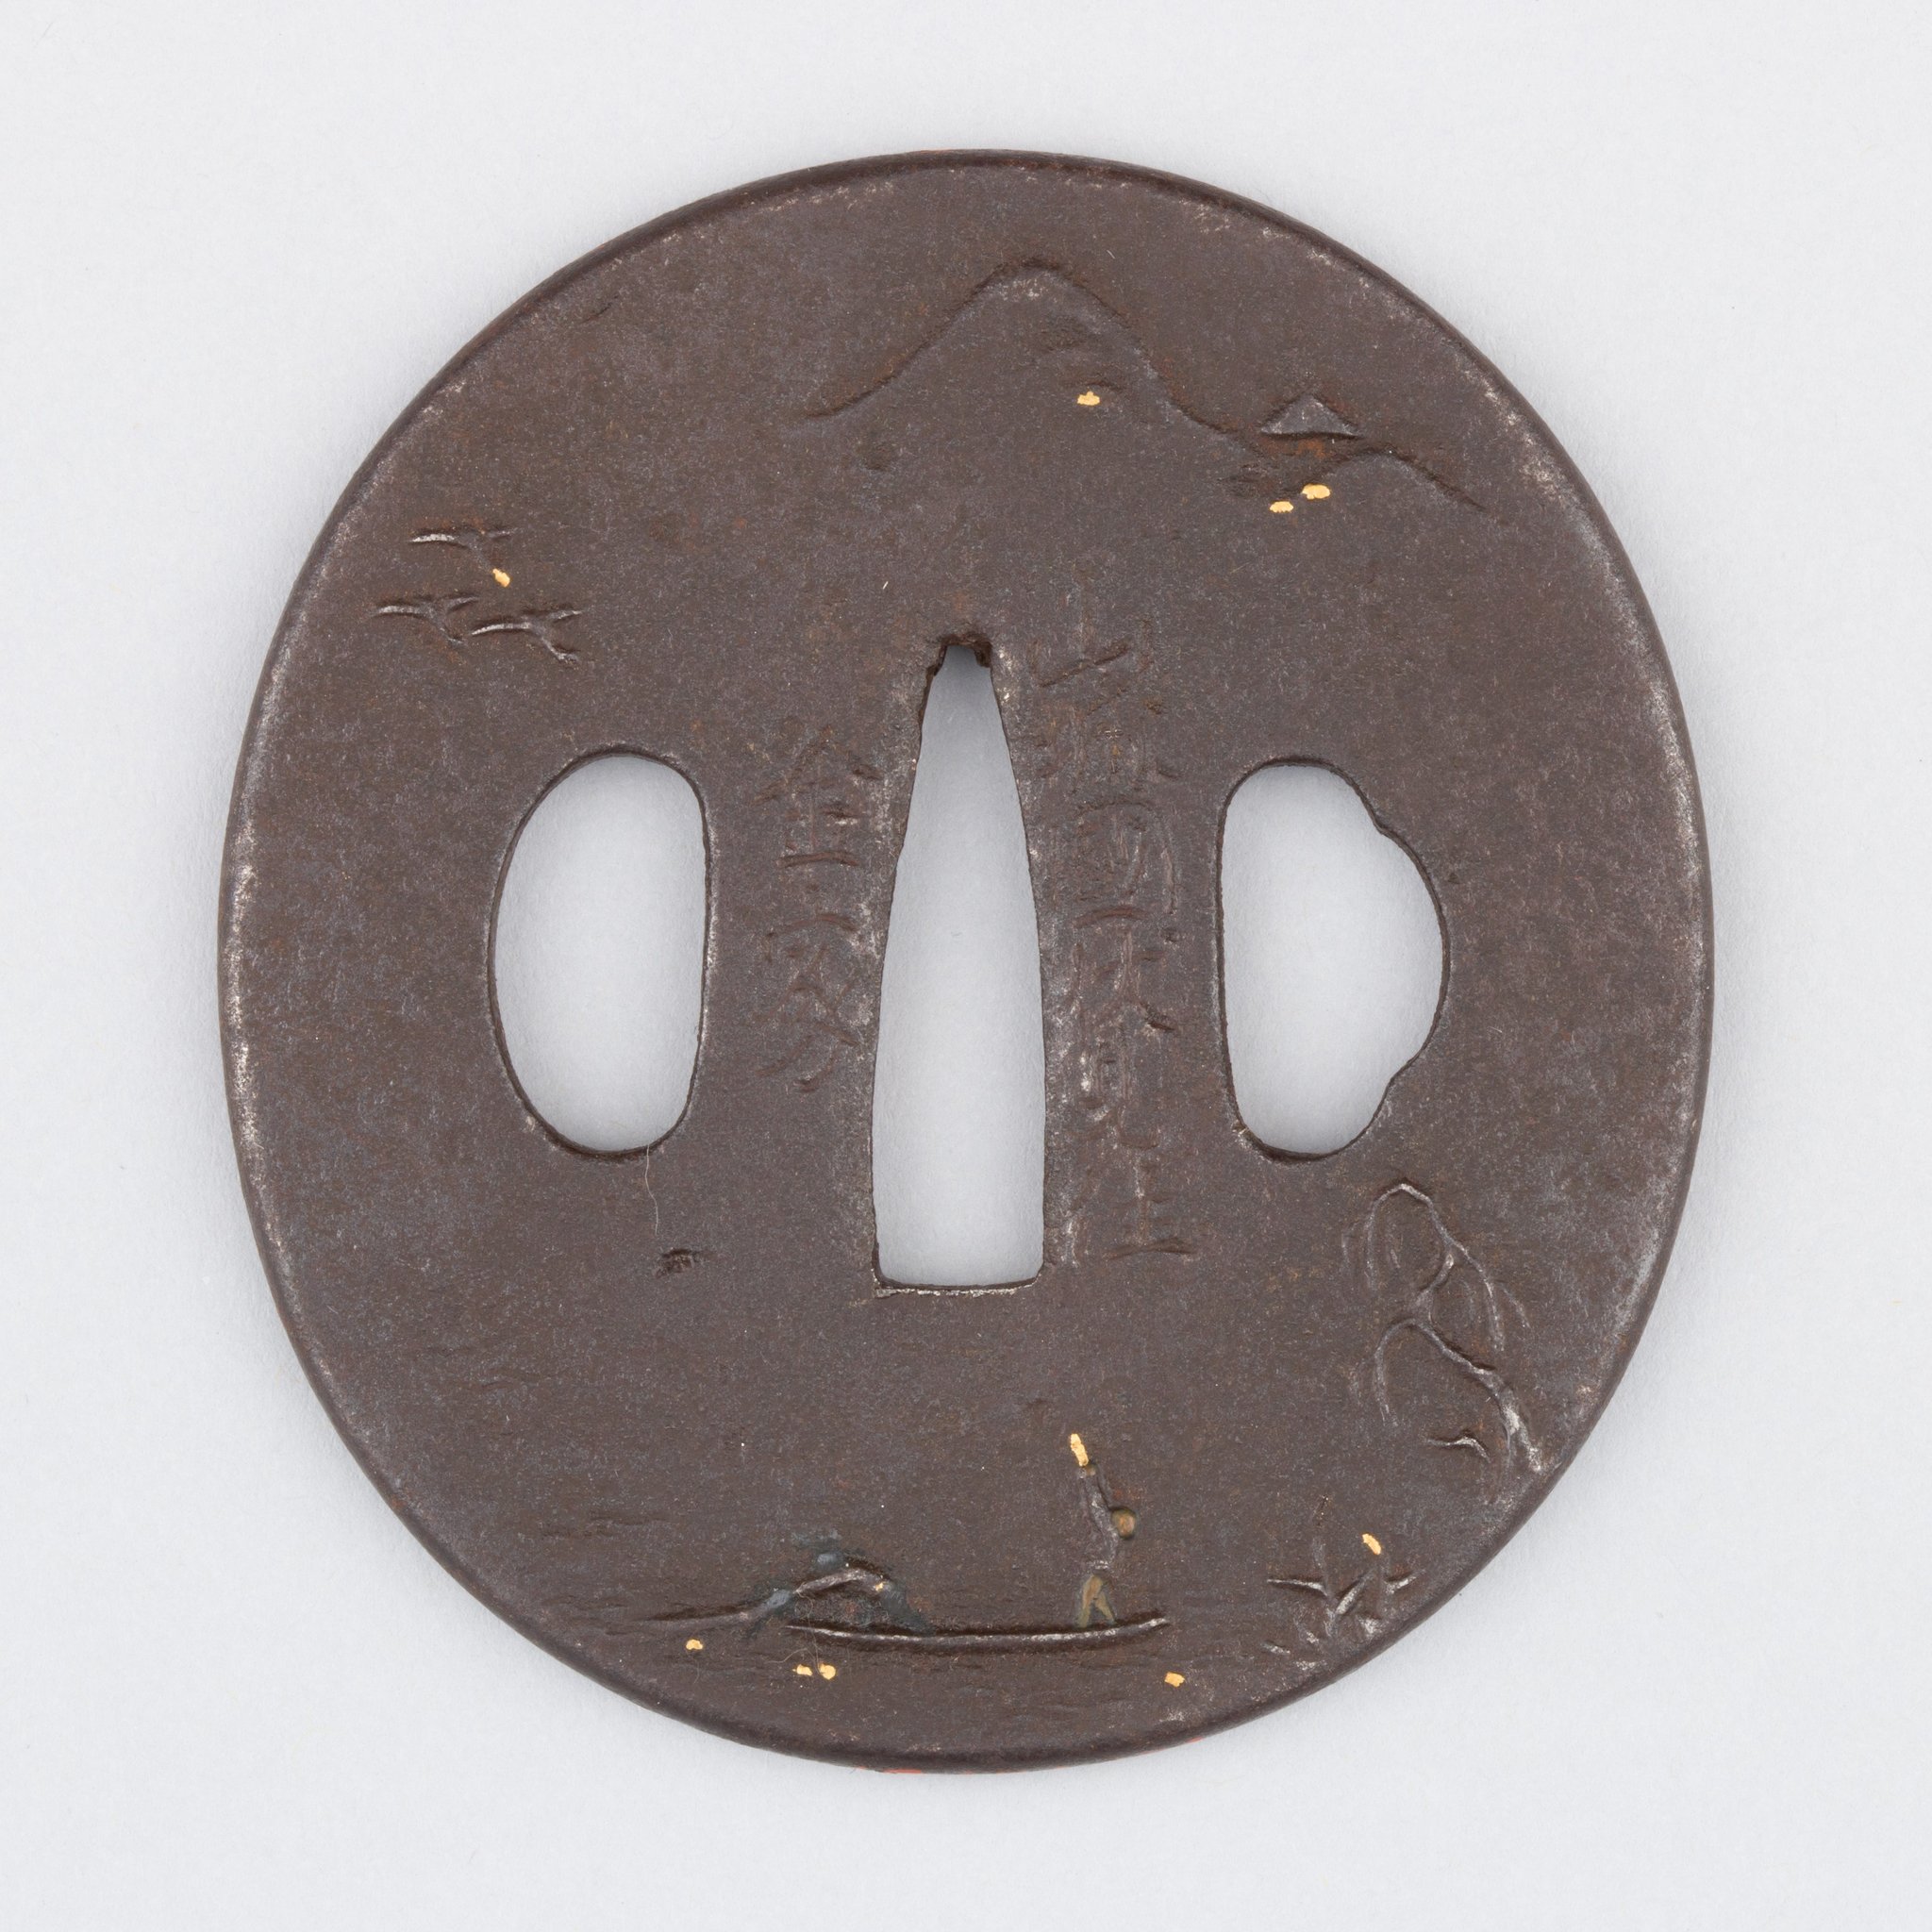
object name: sword guard tsuba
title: Sword Guard (Tsuba)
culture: japanese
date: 1615-1868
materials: copper, iron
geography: japan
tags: birds,mountains,boats